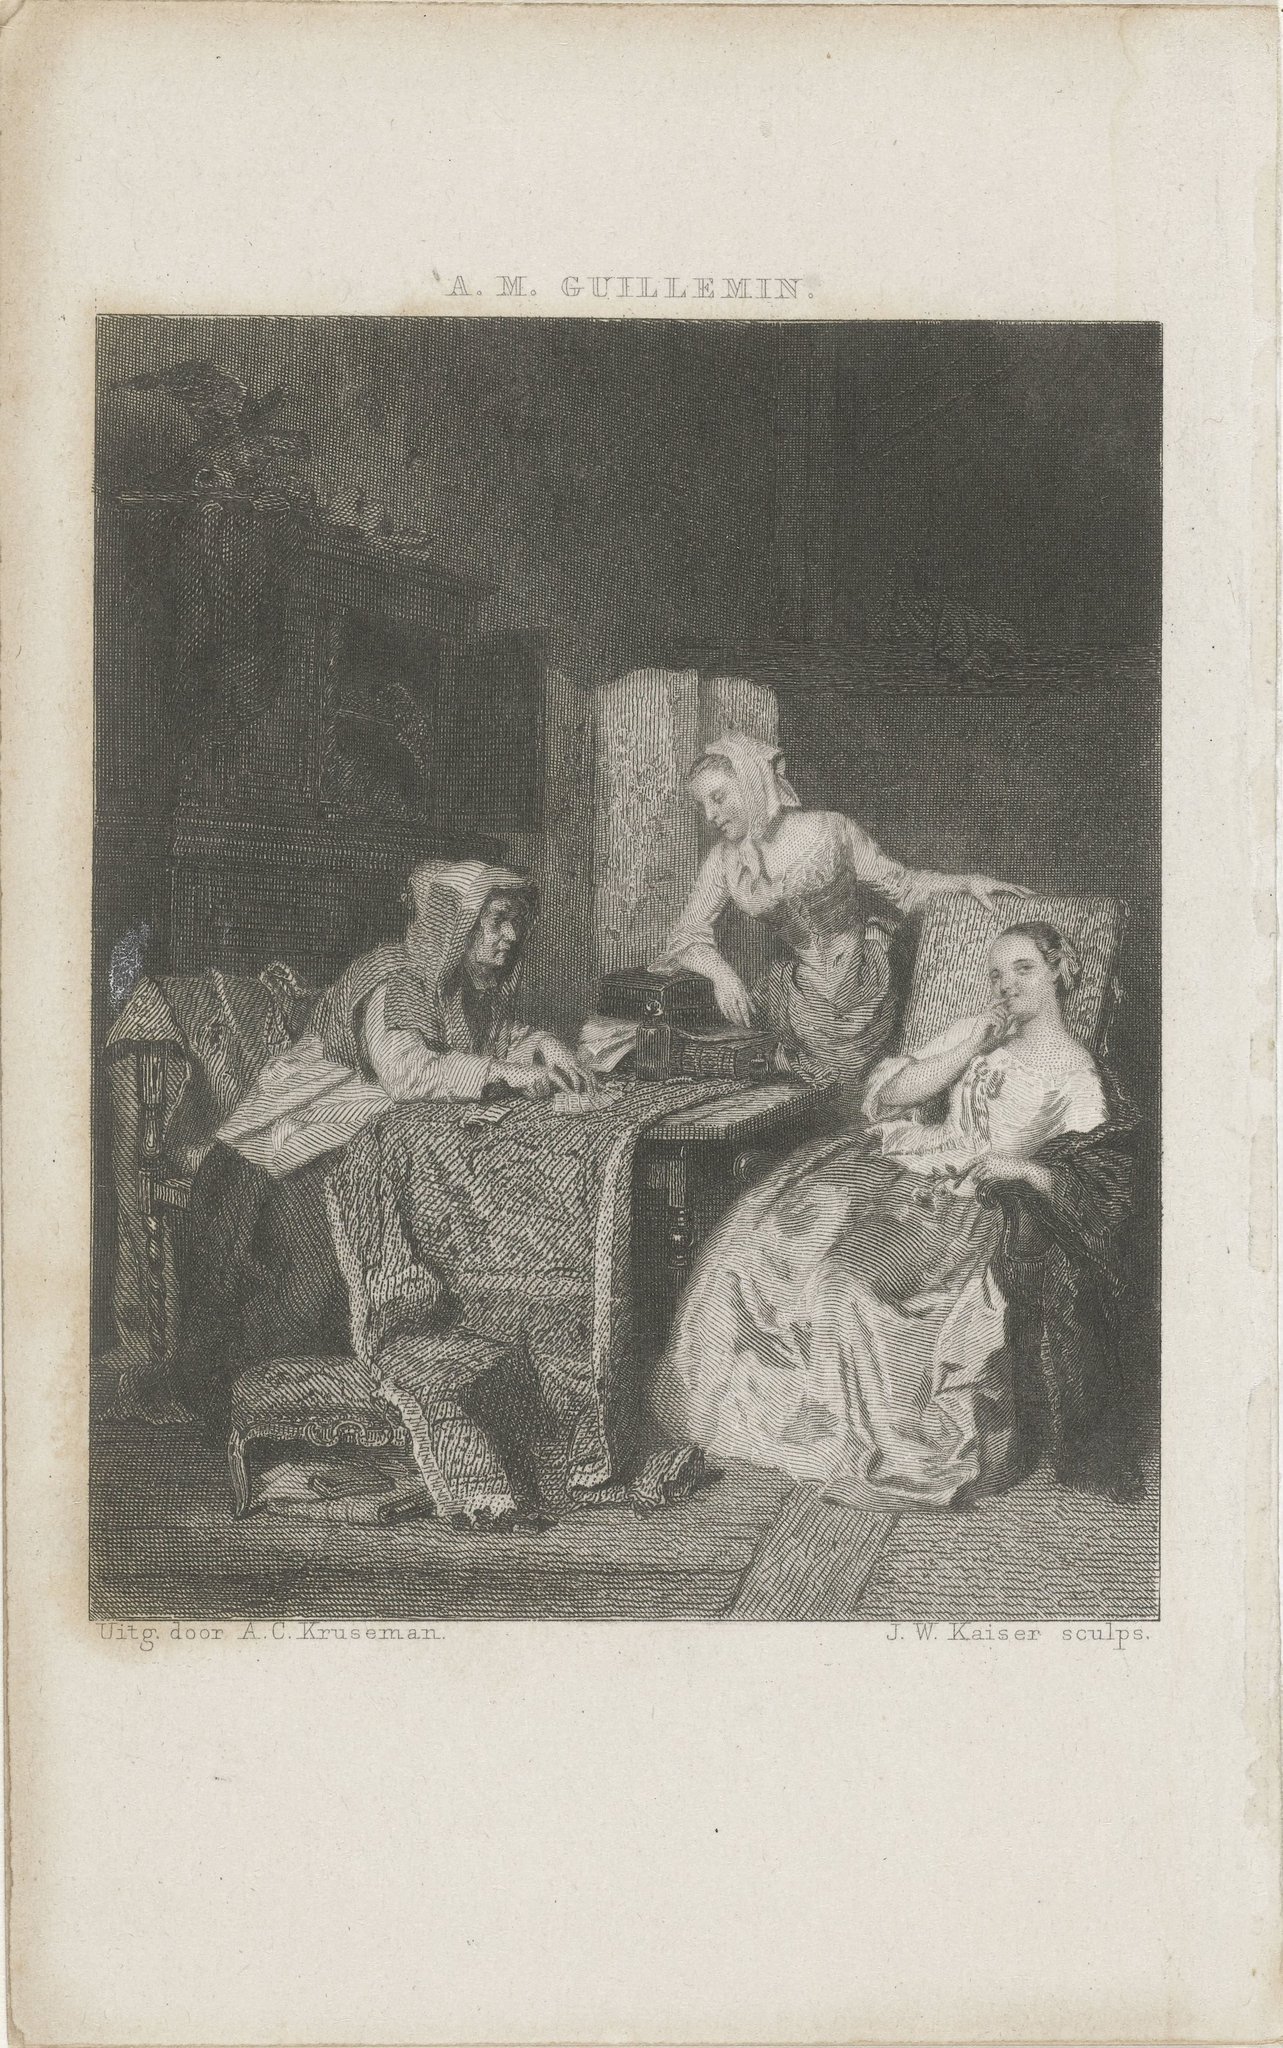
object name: print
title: Waarzegster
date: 1857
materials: paper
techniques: etching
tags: flowers, fortune-teller ~ pleasure fair and circus, divination ~ human corpse, necromancy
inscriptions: inscription: ‘Aurora 1857 Sybilla Orakel waarzeggen’, collector's mark: Lugt 2228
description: In een vertrek heeft een waarzegster haar kaarten op tafel uitgelegd. De jonge vrouw in de stoel tegenover de waarzegster zit met een roos in haar hand te denken of te luisteren terwijl de dienstmeid, die achter haar staat, met een elleboog op een stapel boeken staat te leunen.